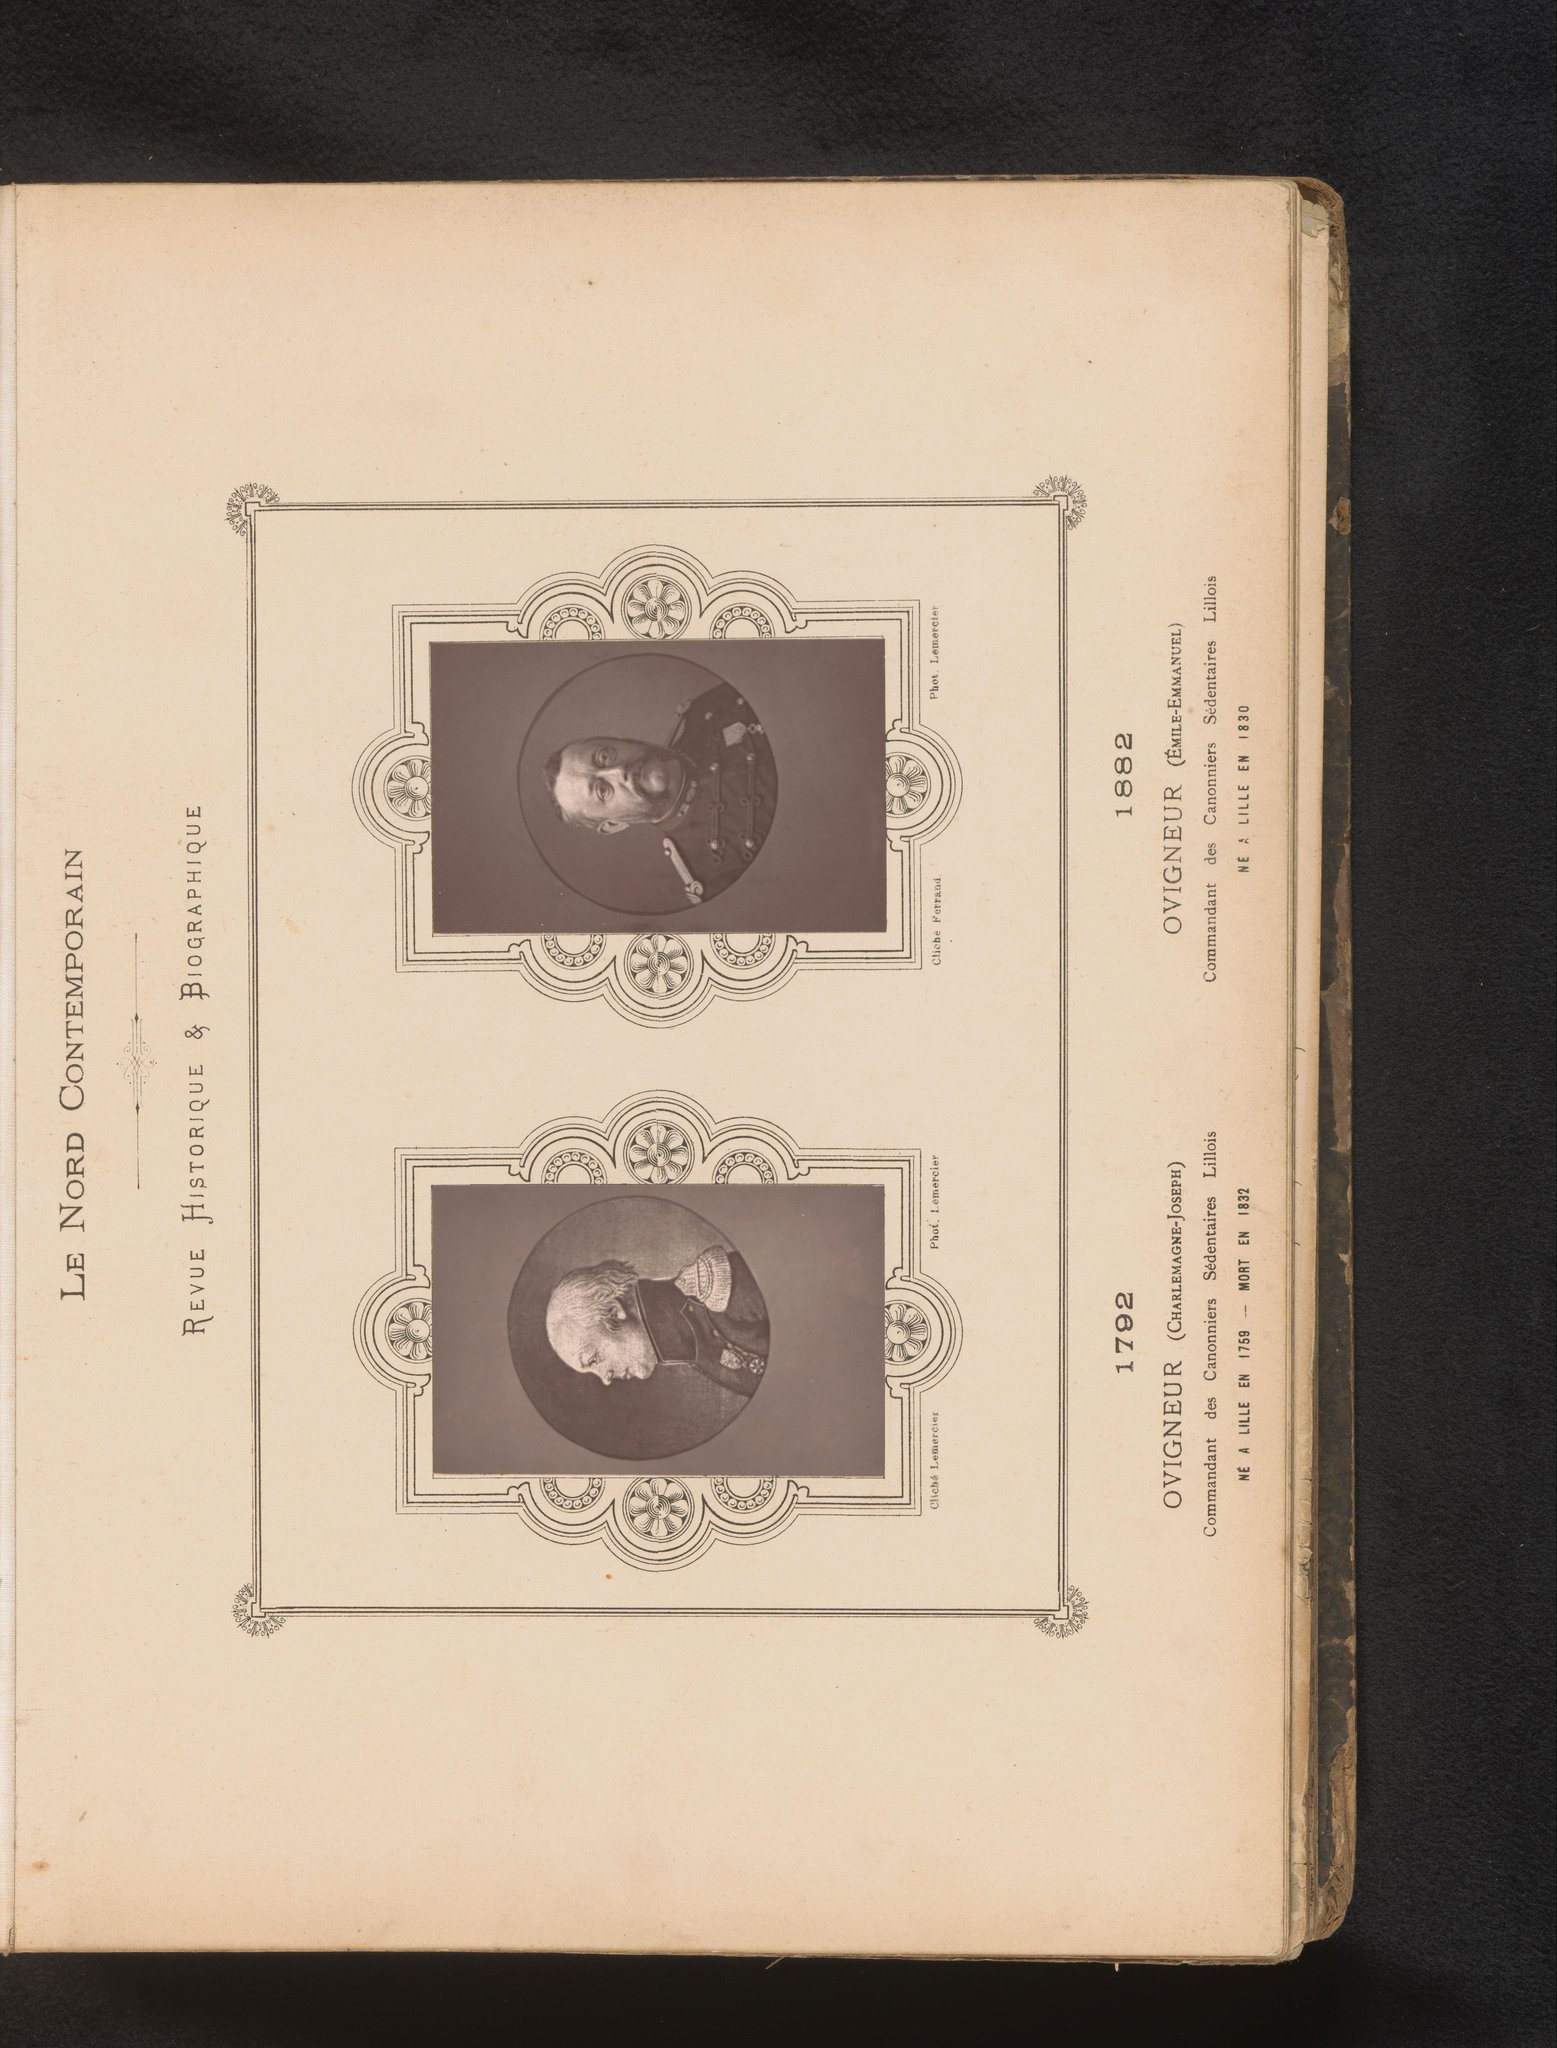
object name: page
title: Portret van Émile-Emmanuel Ovigneur, commandant van de artillerie van Lille in 1882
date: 1877-1882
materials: paper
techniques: woodburytype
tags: lille, historical persons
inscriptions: inscription: ‘Né a Lille en 1830’, inscription: ‘Le Nord Contemporain/ Revue Historique & Biographique’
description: Prent op vijfde ongenummerde pagina na pagina 304.